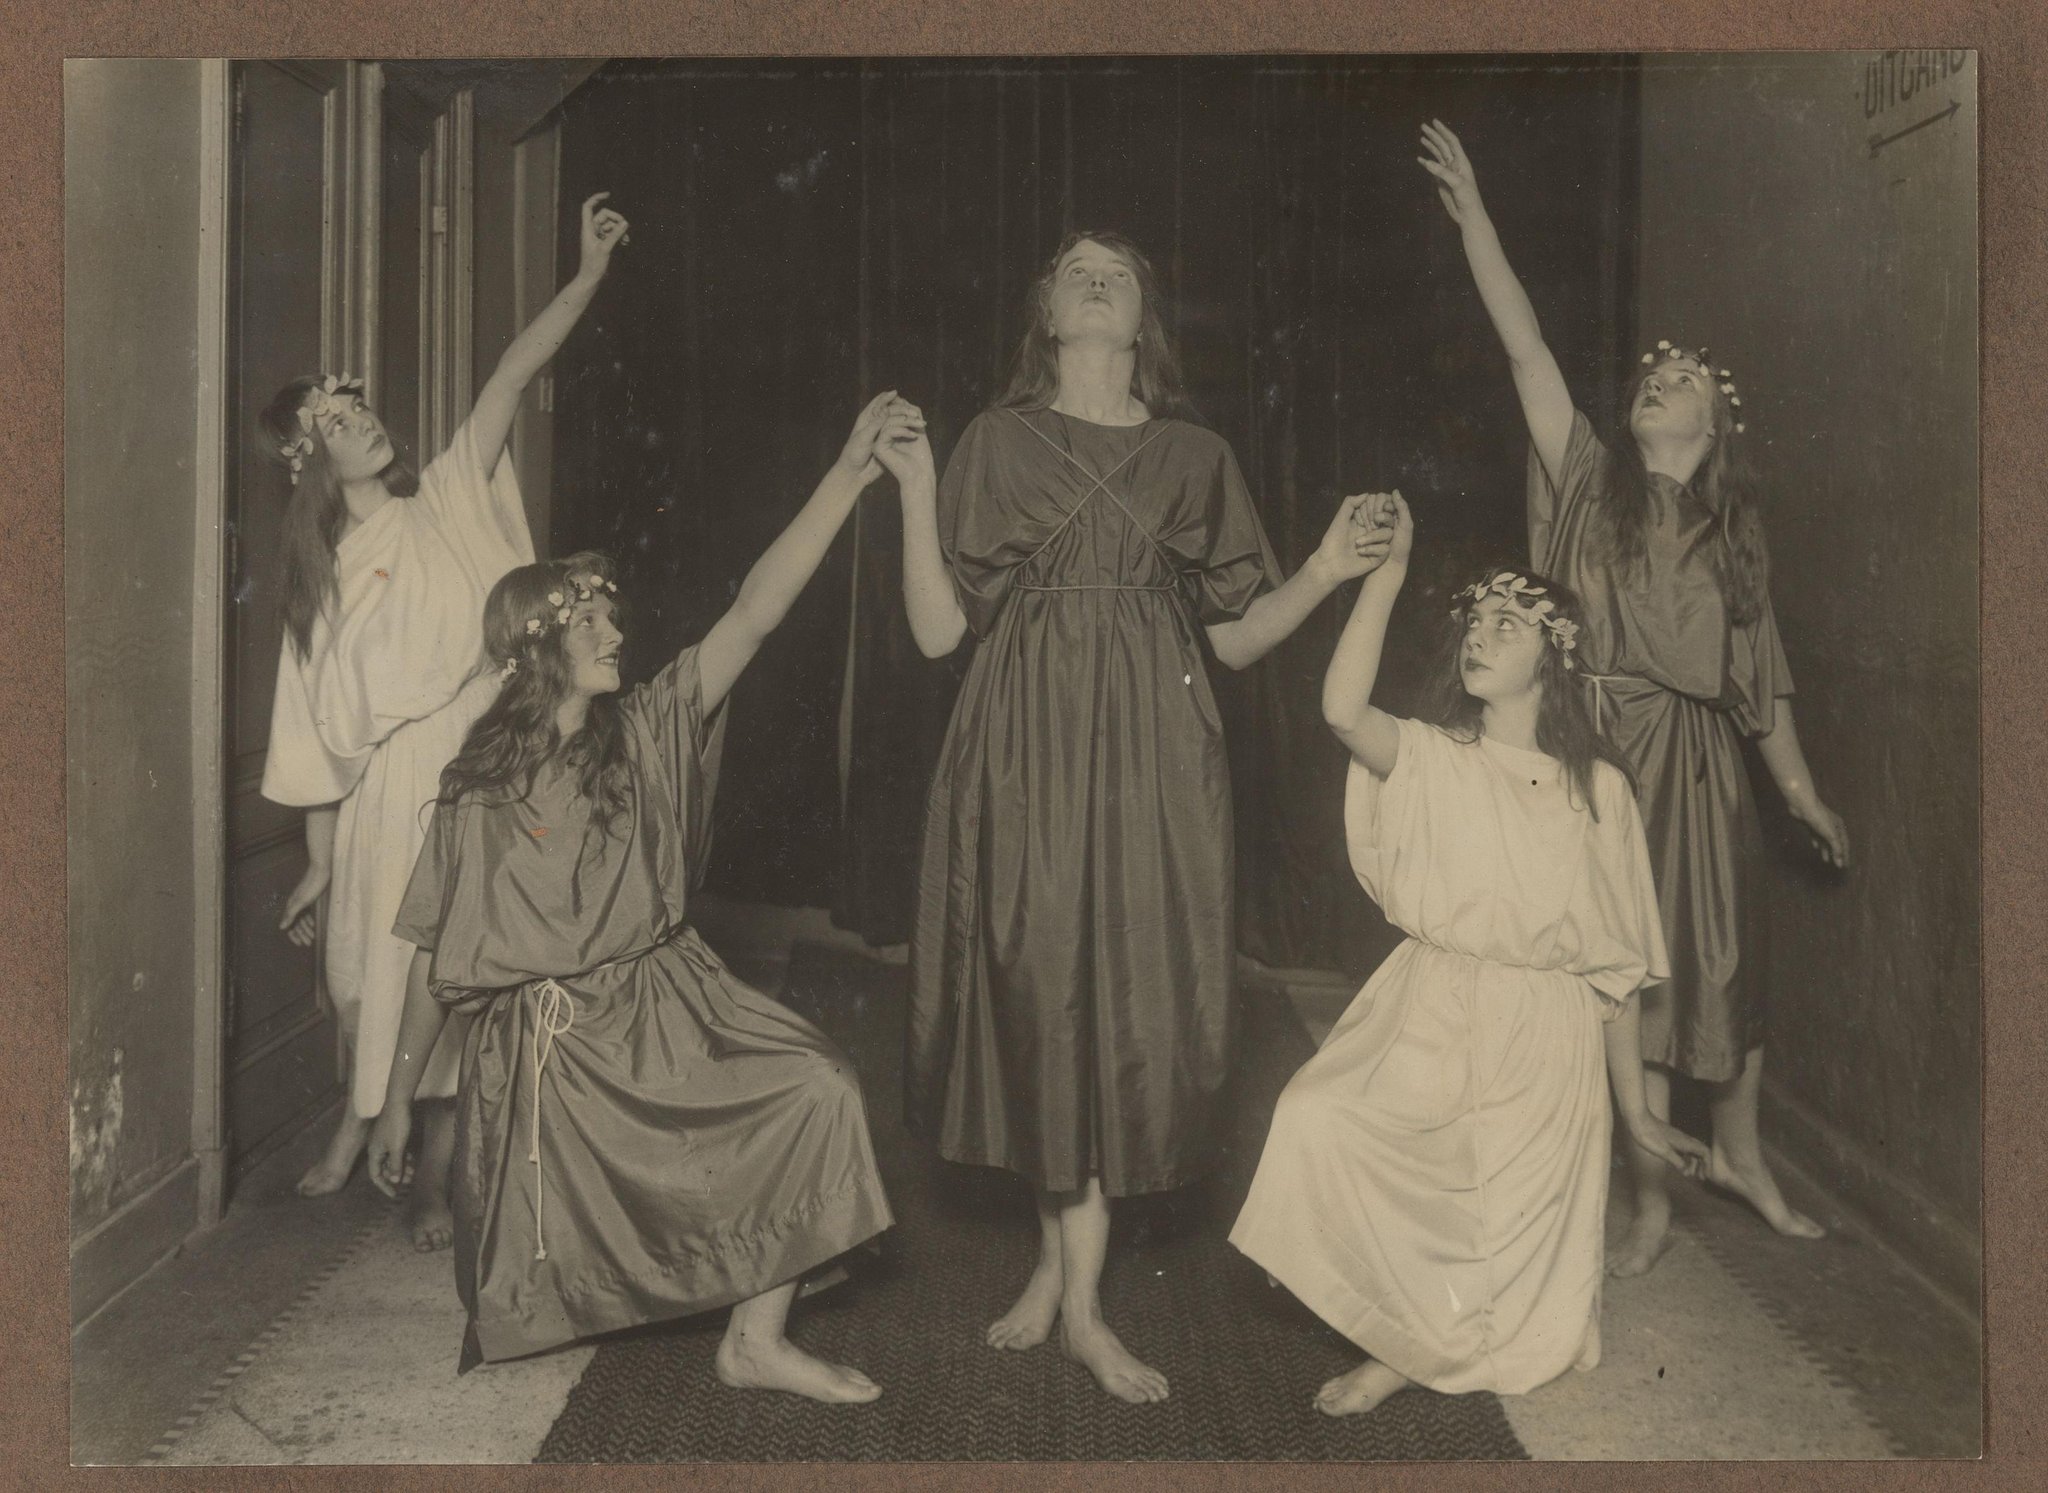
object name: photograph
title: Vijf vrouwen in toneelkostuum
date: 1908-1915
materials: photographic support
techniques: photography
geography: netherlands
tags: netherlands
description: Foto op bruin albumblad 50 van familiealbum van Alphons Diepenbrock.